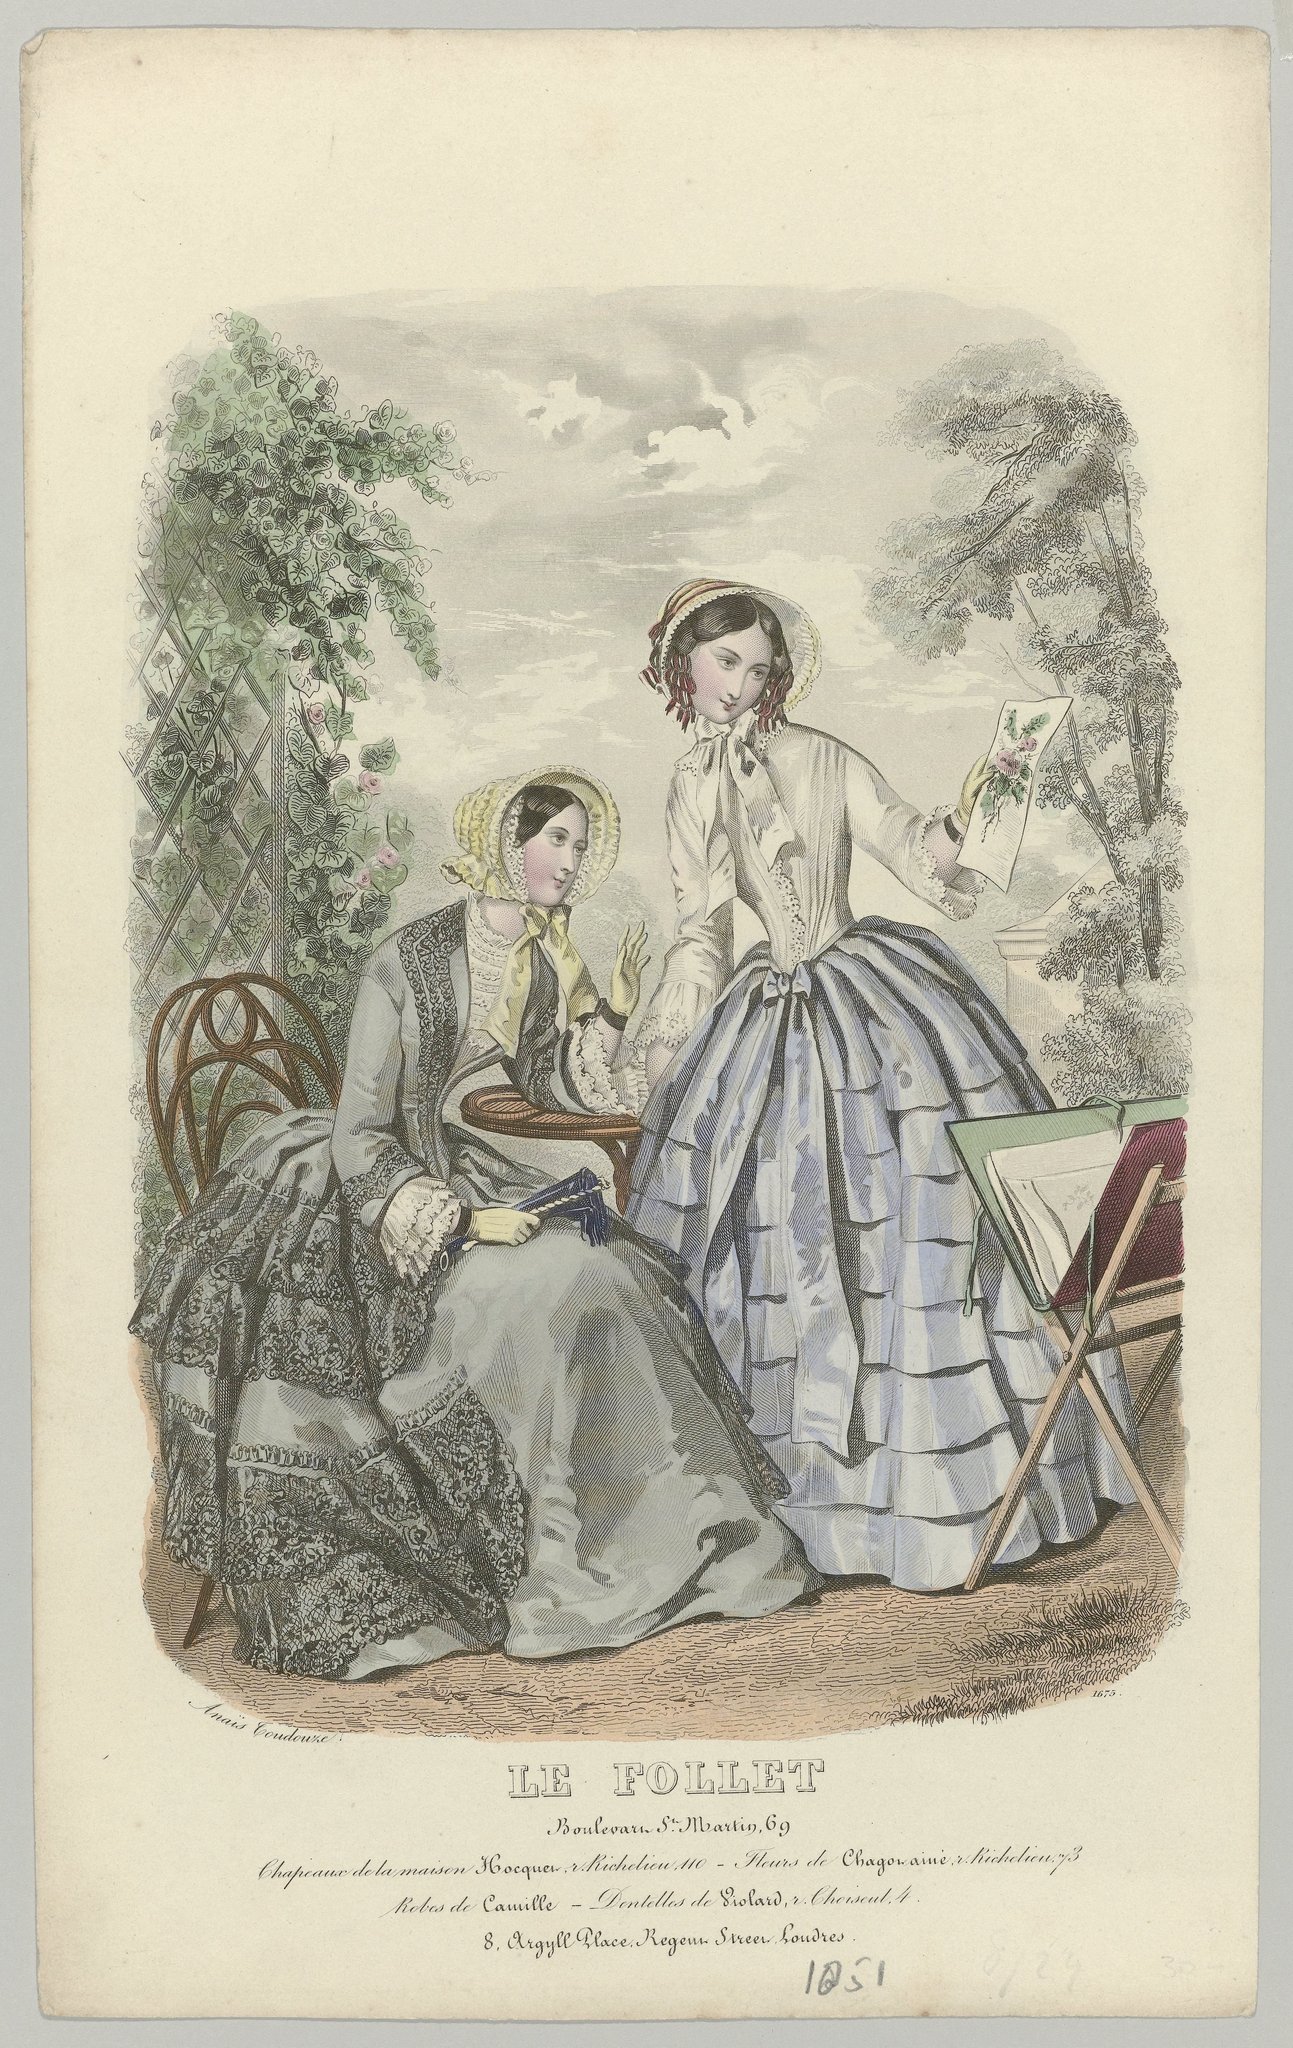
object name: fashion print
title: Le Follet, 1851, No. 1675 : Chapeaux de la maison (...)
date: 1851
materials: paper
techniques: engraving, hand coloring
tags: flowers, clothing for the upper part of the body: blouse (+ women's clothes), lace (+ women's clothes), print, e.g.: engraving, etching, lithograph, fashion plates, head-gear: hat (+ women's clothes), skirt (+ women's clothes), gloves, mittens, etc. (+ women's clothes), bracelet, wristlet (+ women's clothes), parasol, sunshade (+ women's clothes)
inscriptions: title: ‘Le Follet’, caption: ‘Chapeaux de la maison Hocquet,r. Richelieu, 110 - Fleurs de Chagot ainé, r. Richelieu, 73 Robes de Camille - Dentelles de Violard, r. Choiseul, 4.’, address: ‘Boulevart S.t Martin, 69 / 8, Argyll Place. Regent Street Londres.’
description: Twee vrouwen in een tuin bij een geopend album met prenten of tekeningen in een standaard. Onder de voorstelling enkele regels reclametekst voor verschillende producten. Prent uit het modetijdschrift Le Follet Courrier des Salons (novembre 1829-octobre 1882).